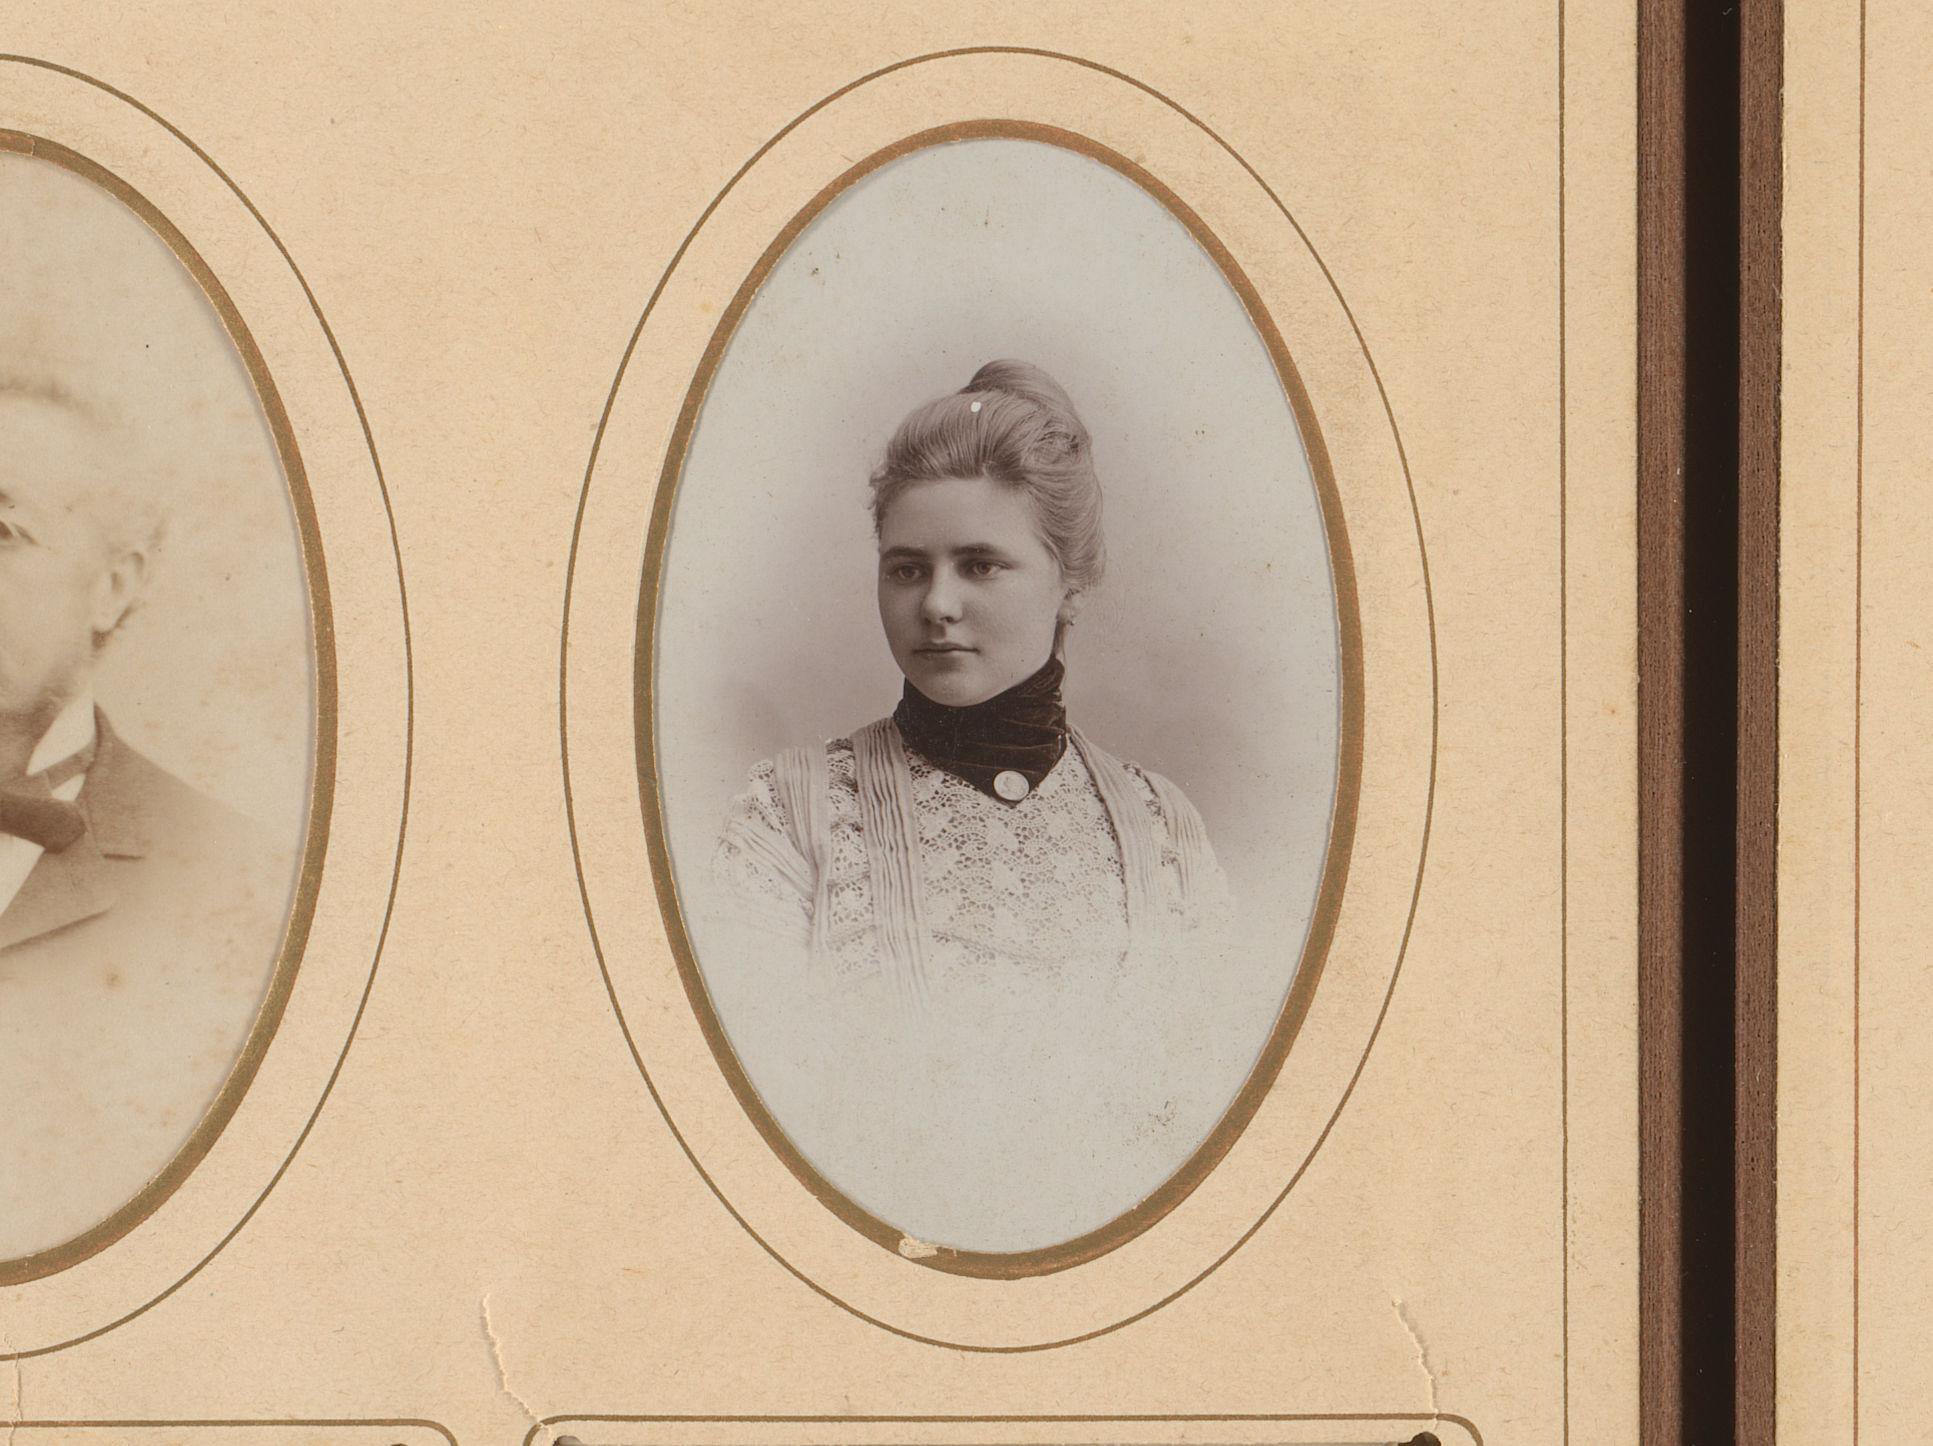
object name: carte de visite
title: Portret van een onbekende vrouw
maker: machiel hendricus laddé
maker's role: fotograaf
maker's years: 1866-1932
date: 1892-1906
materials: paper, cardboard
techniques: collodion silver print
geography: amsterdam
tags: anonymous historical person portrayed - bb - woman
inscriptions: address: ‘boven de firma/ MERKELBACH & Co./ AMSTERDAM/ 57-59/ NIEUWENDIJK’